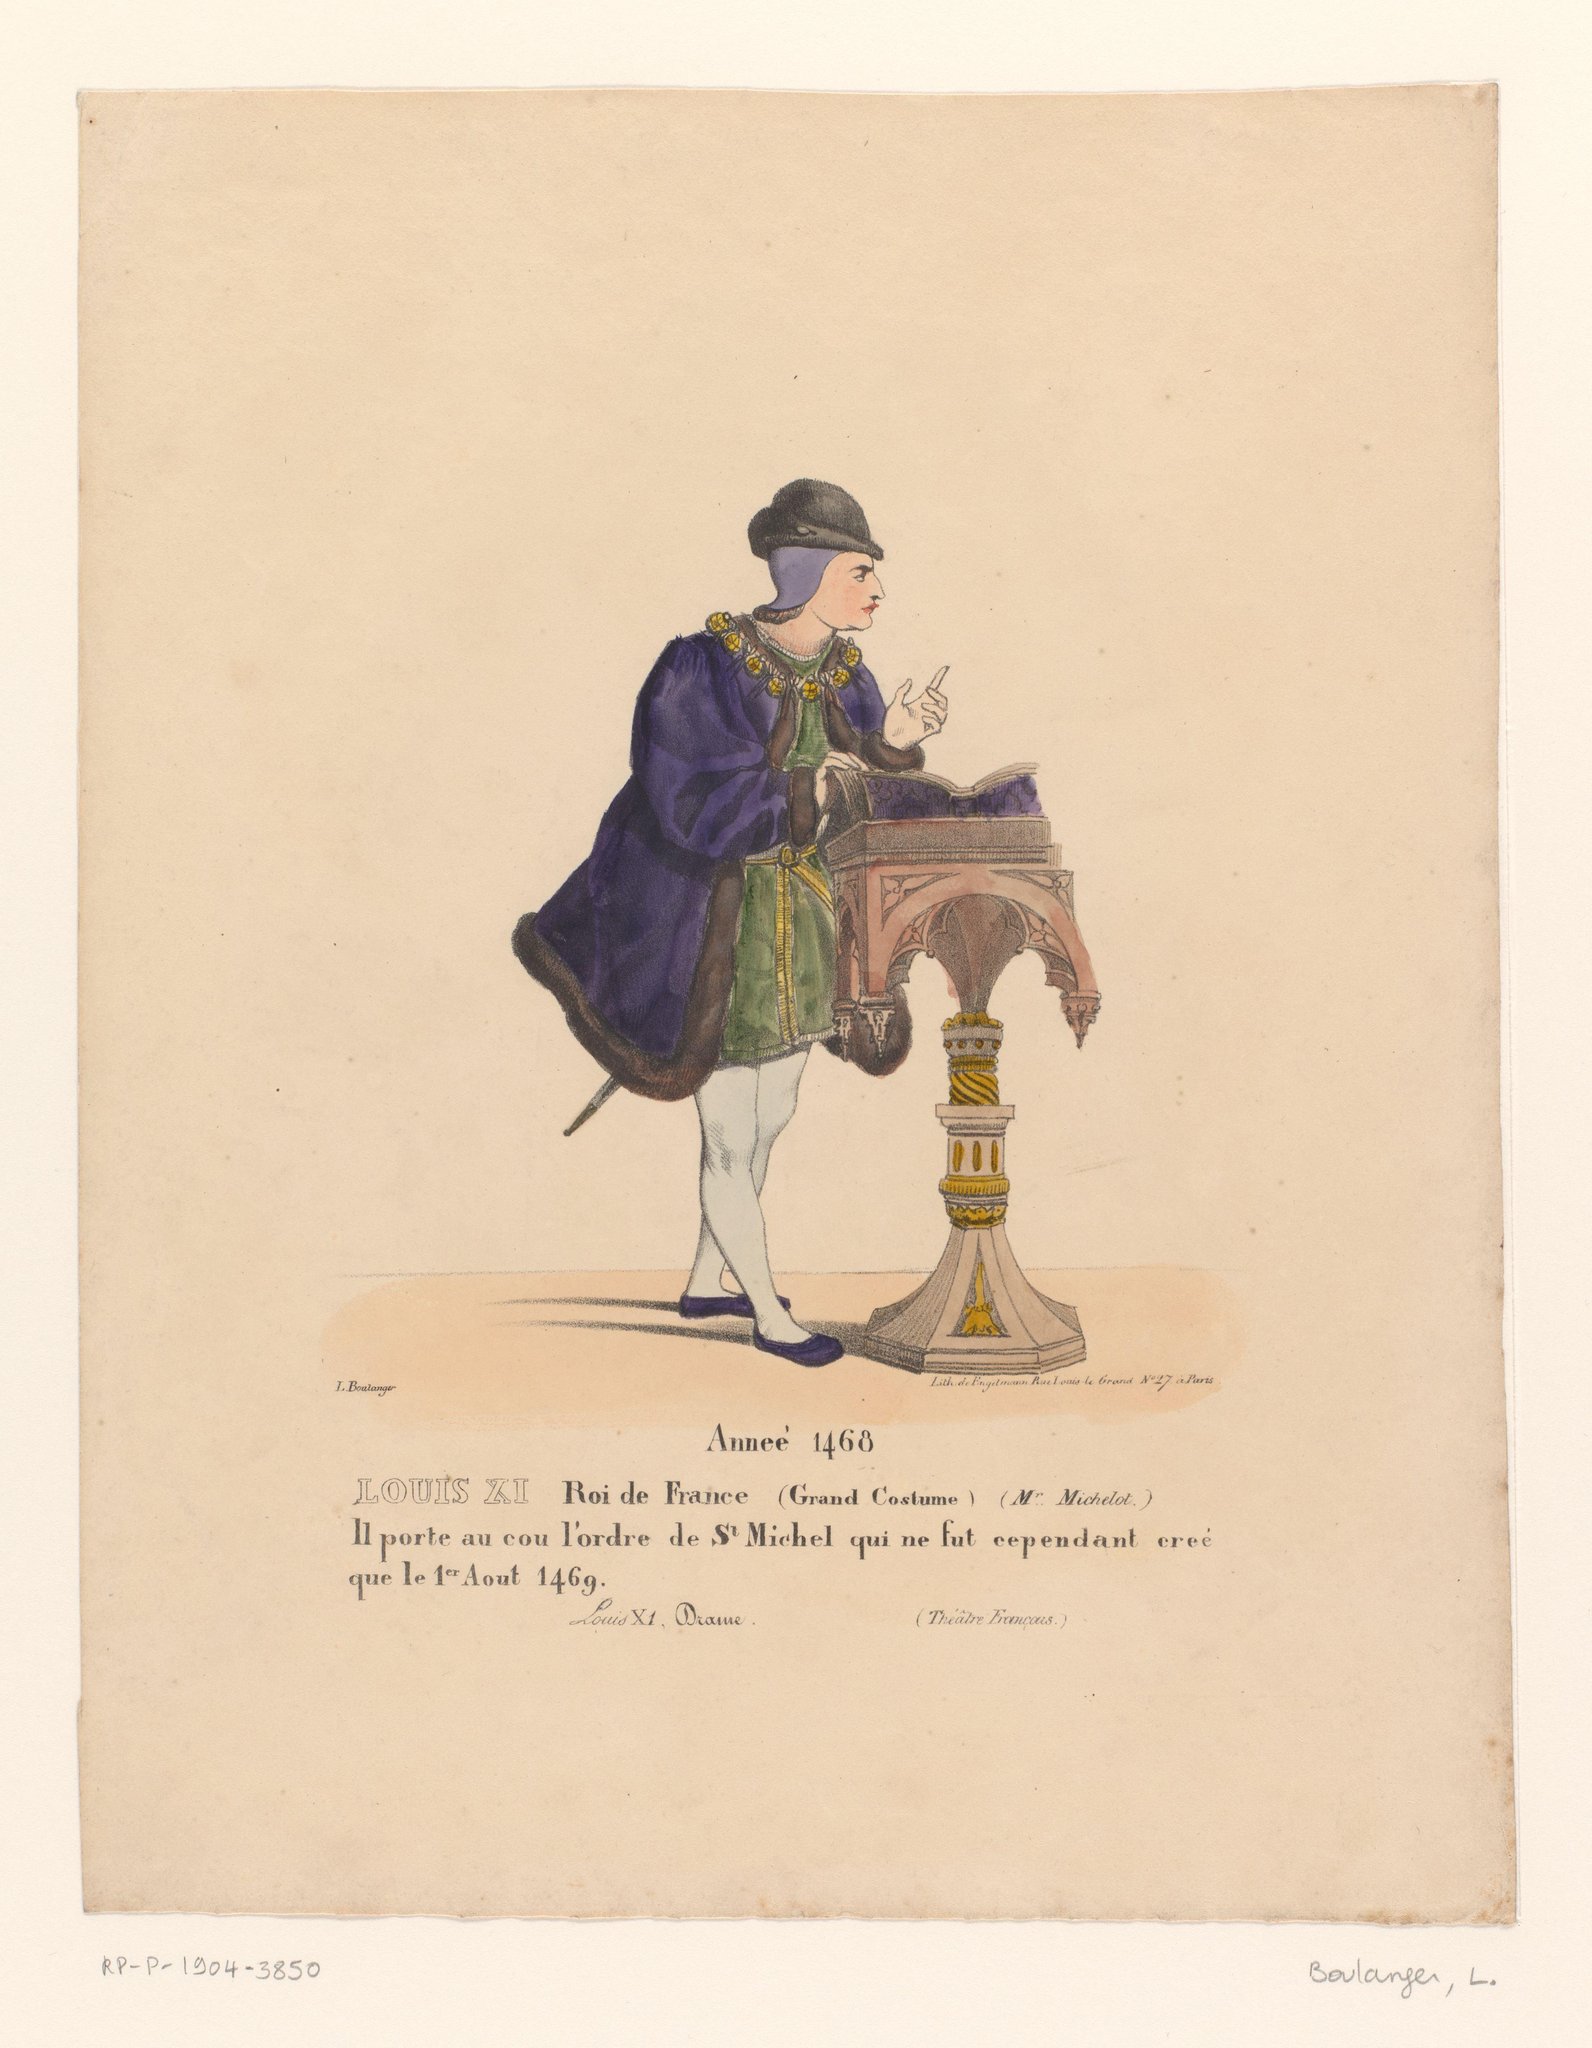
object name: print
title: Louis XI, Roi de France (Grand Costume)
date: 1826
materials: paper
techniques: hand coloring, lithograph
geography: paris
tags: stage costume, historical persons, actor (on the stage), tragedy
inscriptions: collector's mark: Lugt 2228a